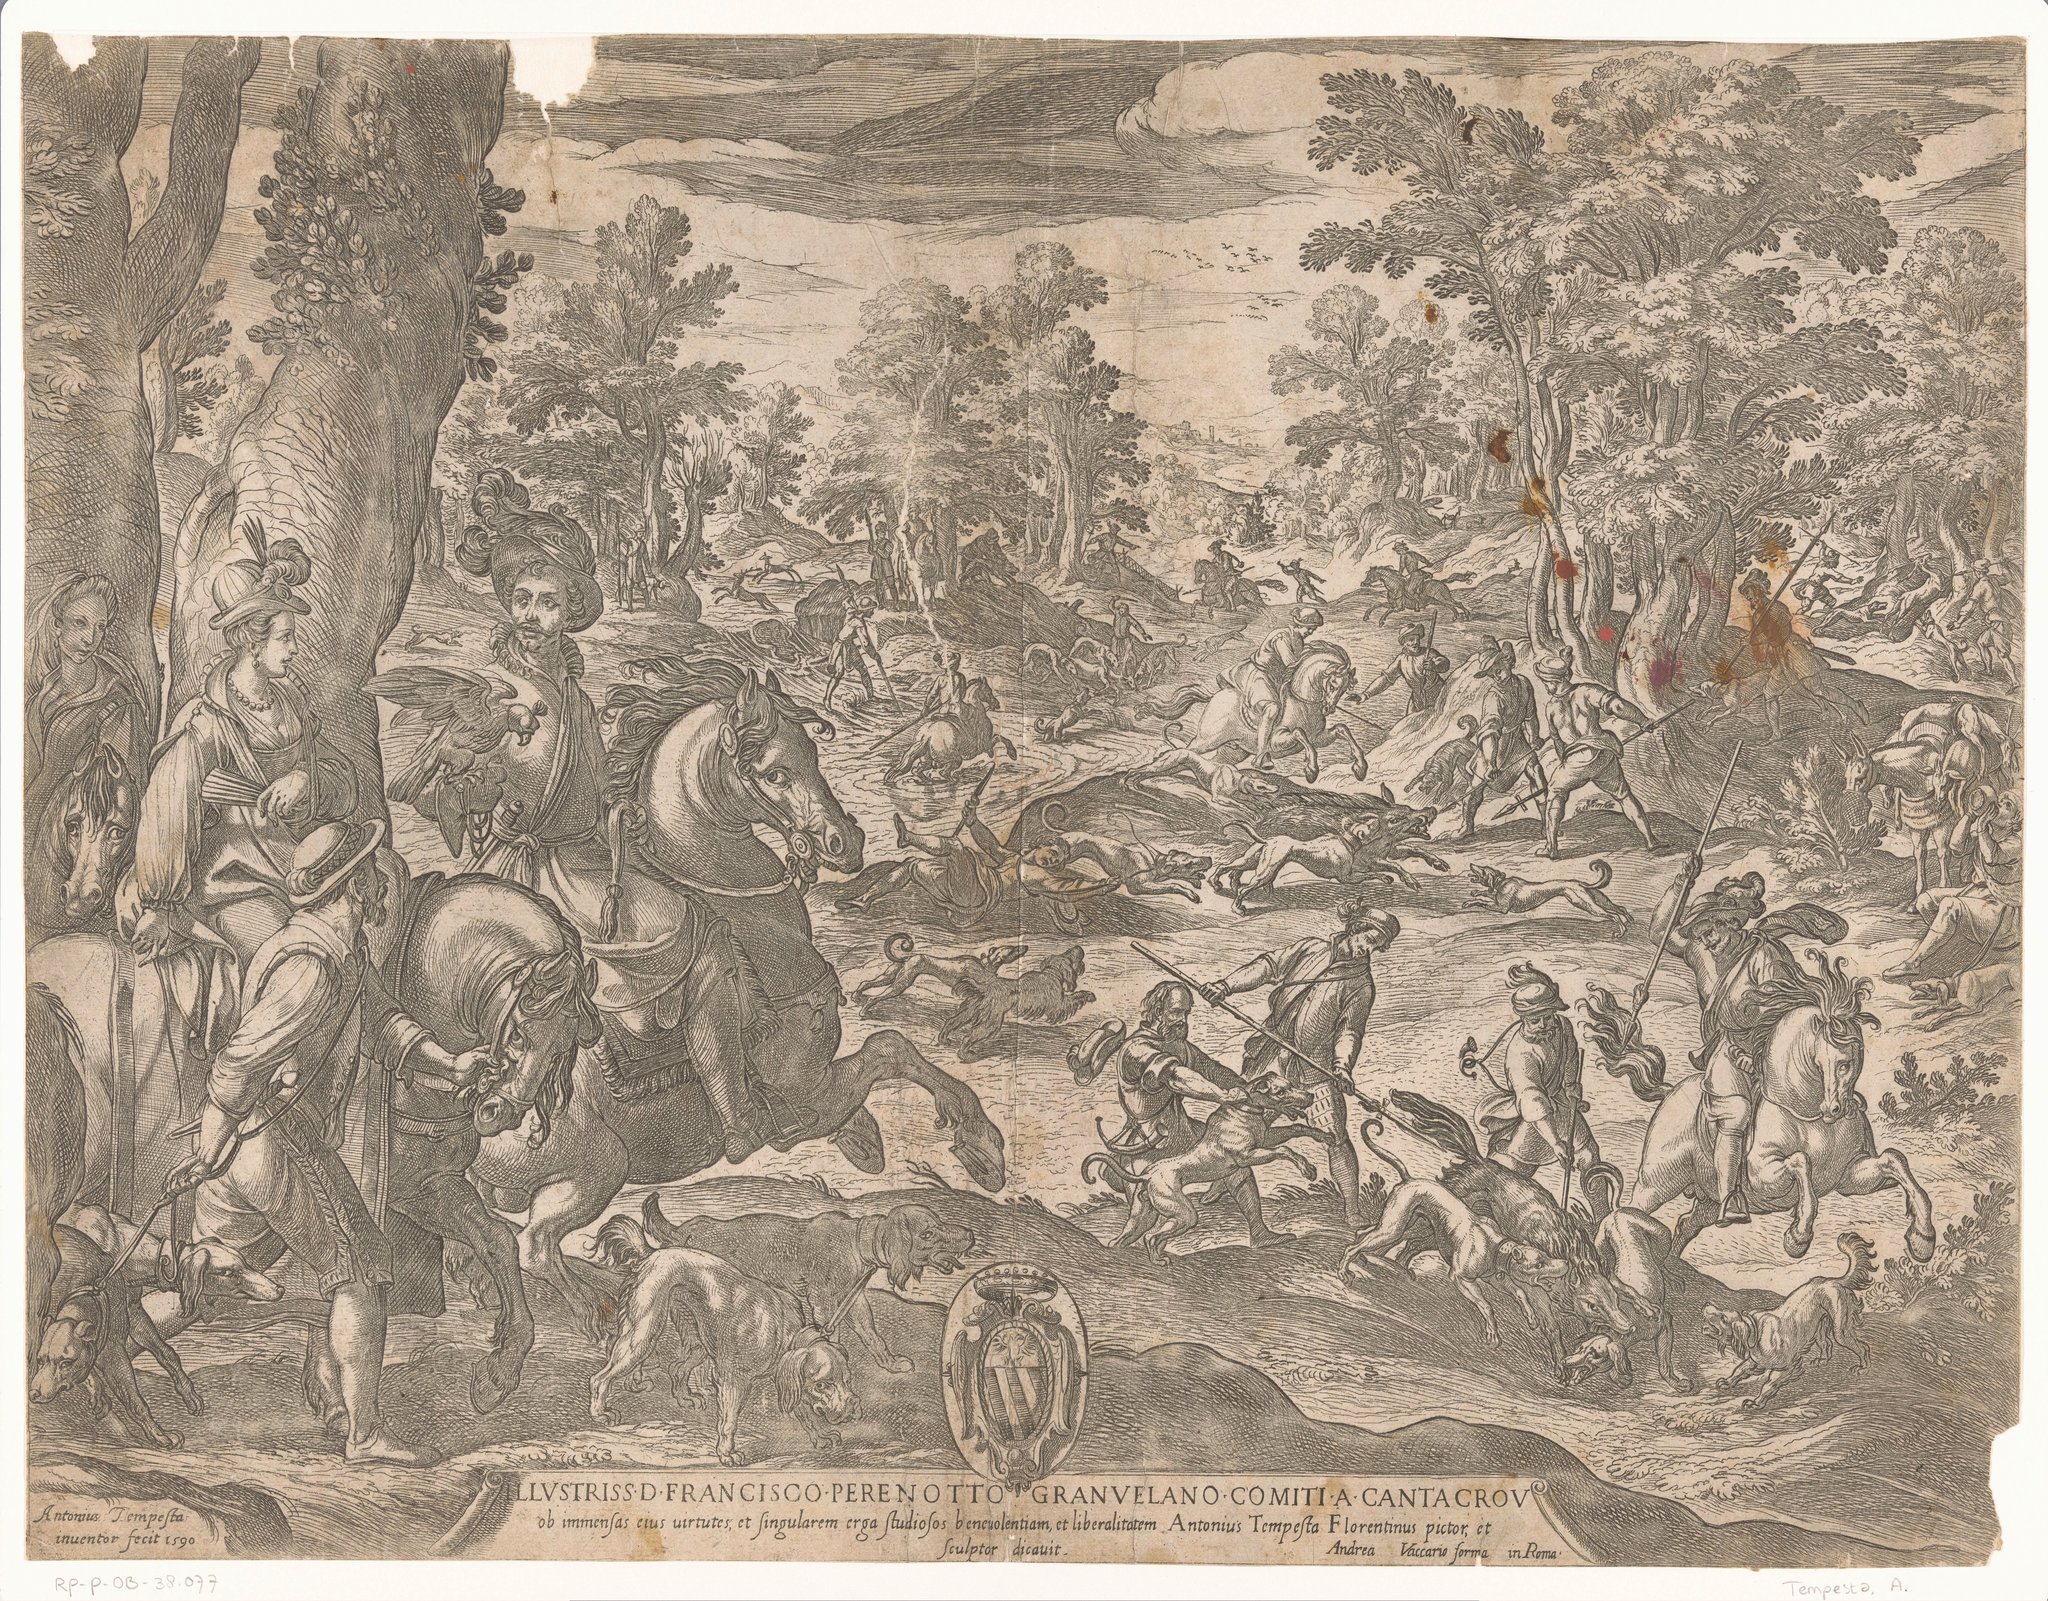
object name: print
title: Jachtsscène met heer een dame toekijkend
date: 1590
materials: paper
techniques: etching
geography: italy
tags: stag-hunting, boar-hunting, hunter, hunters hunting (n.b.: in 1988-1990 this notation denoted the concept of 43c11421 'hunters resting during the hunt'), beasts of prey, predatory animals: wolf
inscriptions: date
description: Landschap met jagers en jachthonden jagend op wolven, everzwijnen en herten. Op de voorgrond links een heer en een dame te paard. Midden onder een wapenschild en cartouche met opdracht.